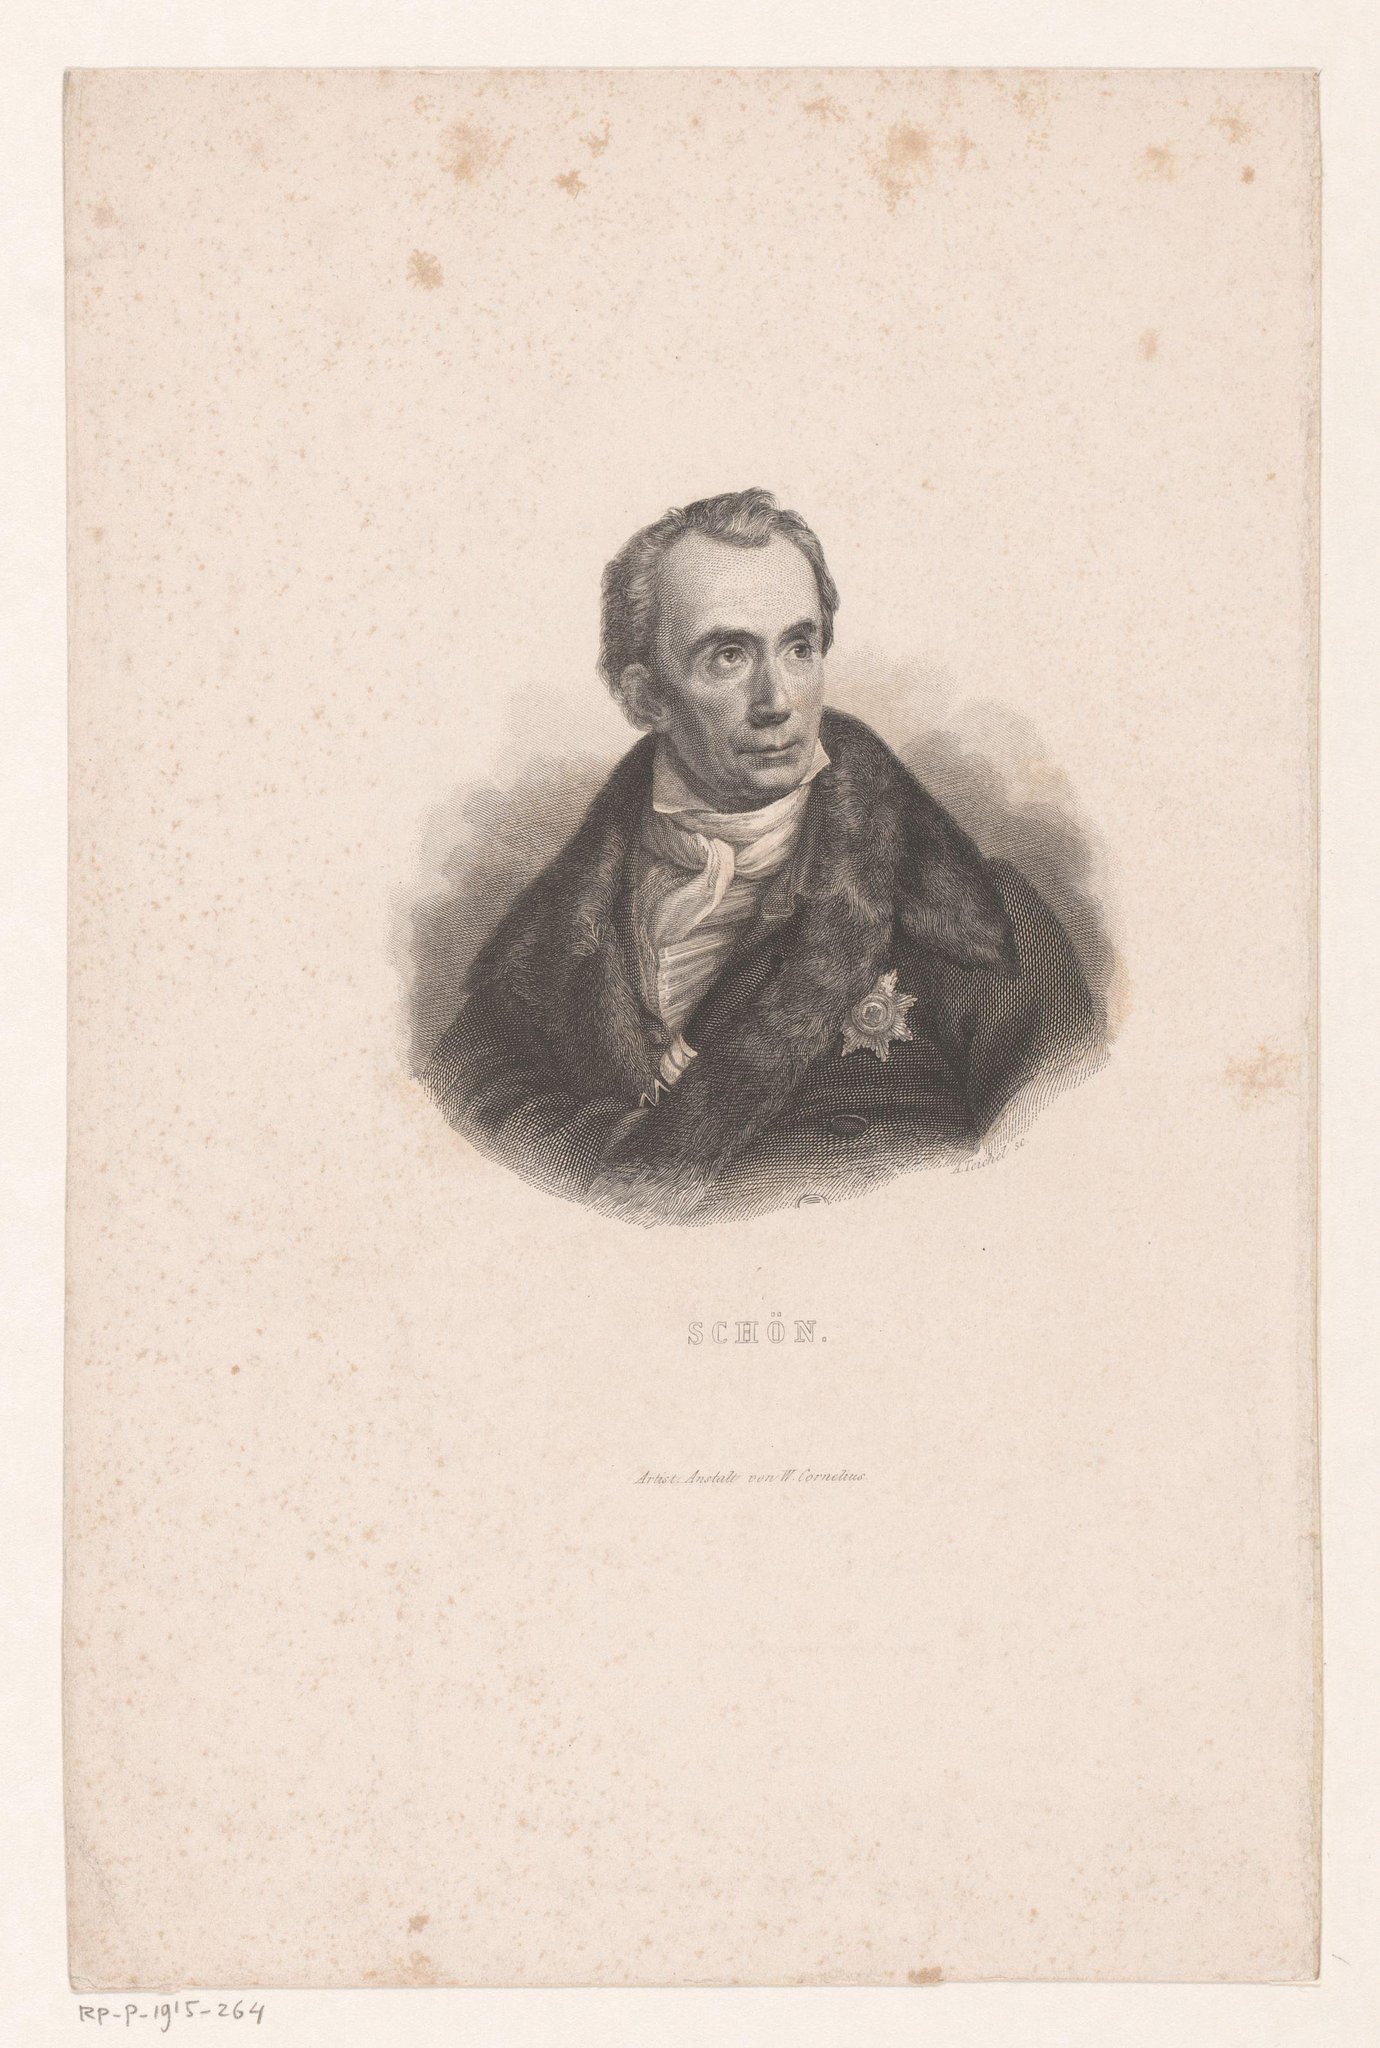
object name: print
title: Portret van Heinrich Theodor von Schön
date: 1832-1873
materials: paper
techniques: engraving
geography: germany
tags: politician, historical persons